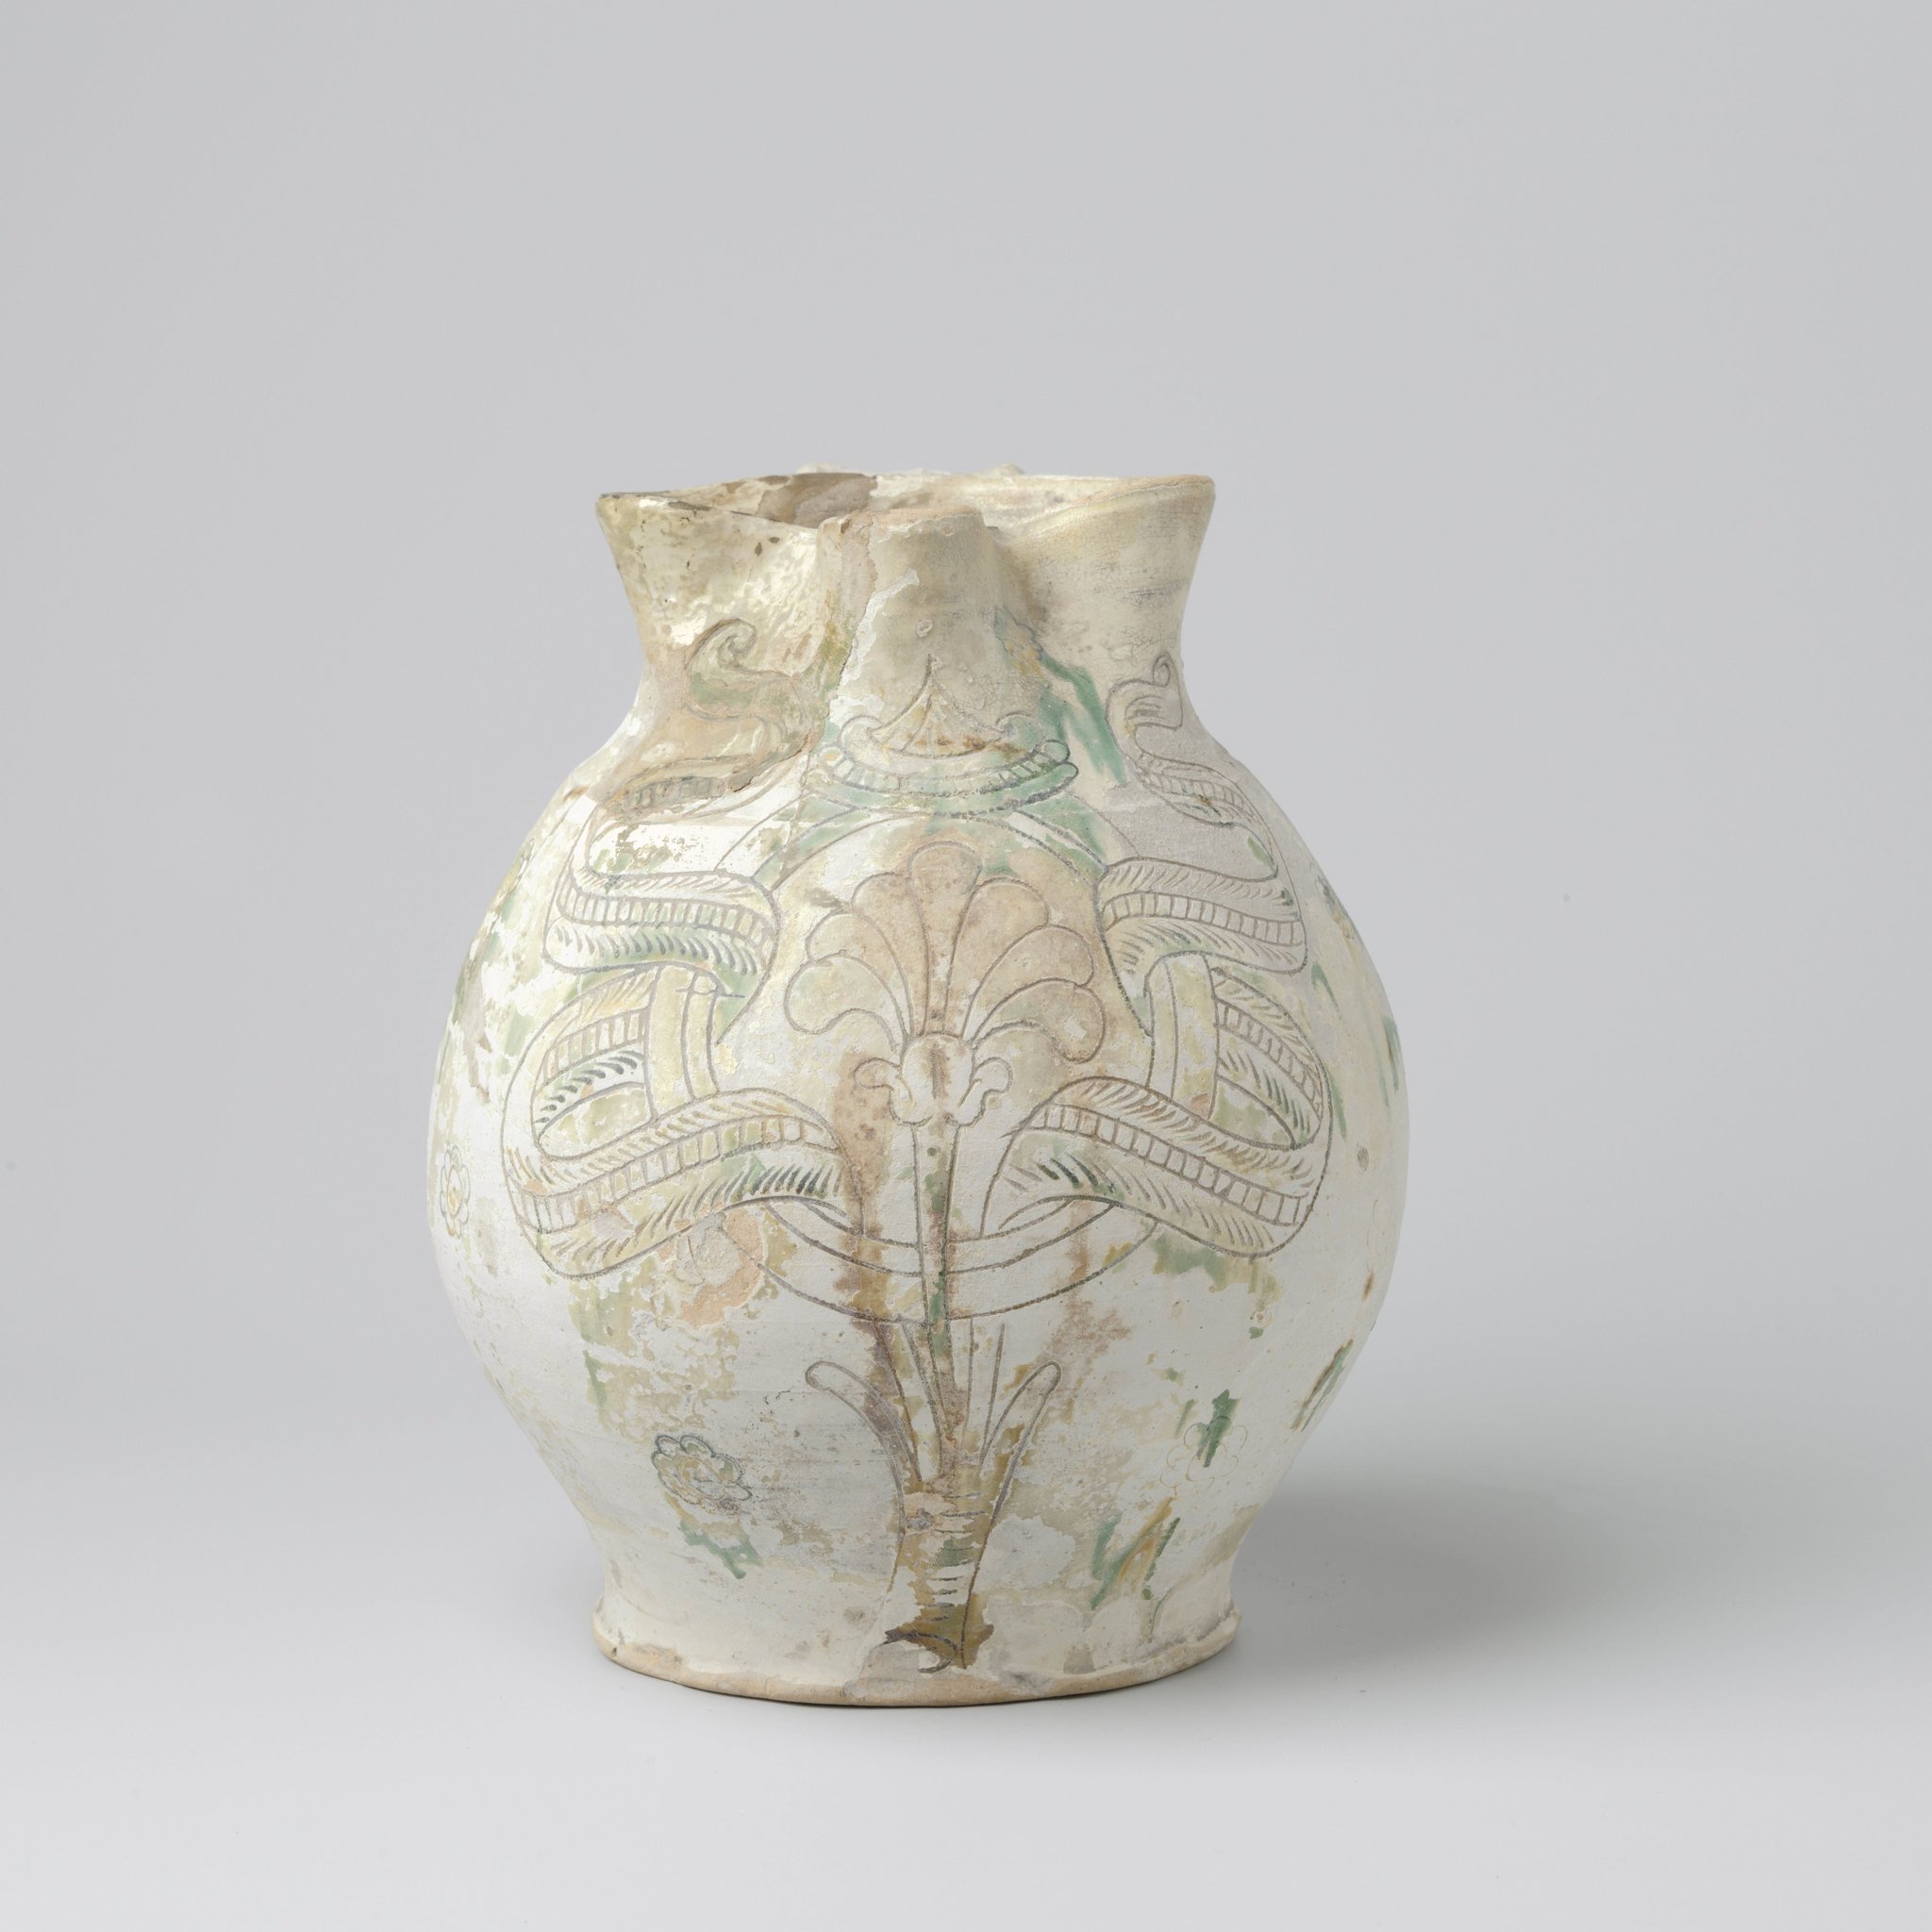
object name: ewer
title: Kan, bolvormig met klaverbladvormige monding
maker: Anonymous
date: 1450-1550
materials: earthenware, glaze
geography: italy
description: Bolvormige kan van loodglazuur aardewerk, op een voet en met een klaverbladvormige monding. De kan heeft een breed, plat oor. In de kan is een bloem waar omheen concentrische cirkels gegrift. Om de cirkels slingeren zich twee gestreepte banden.